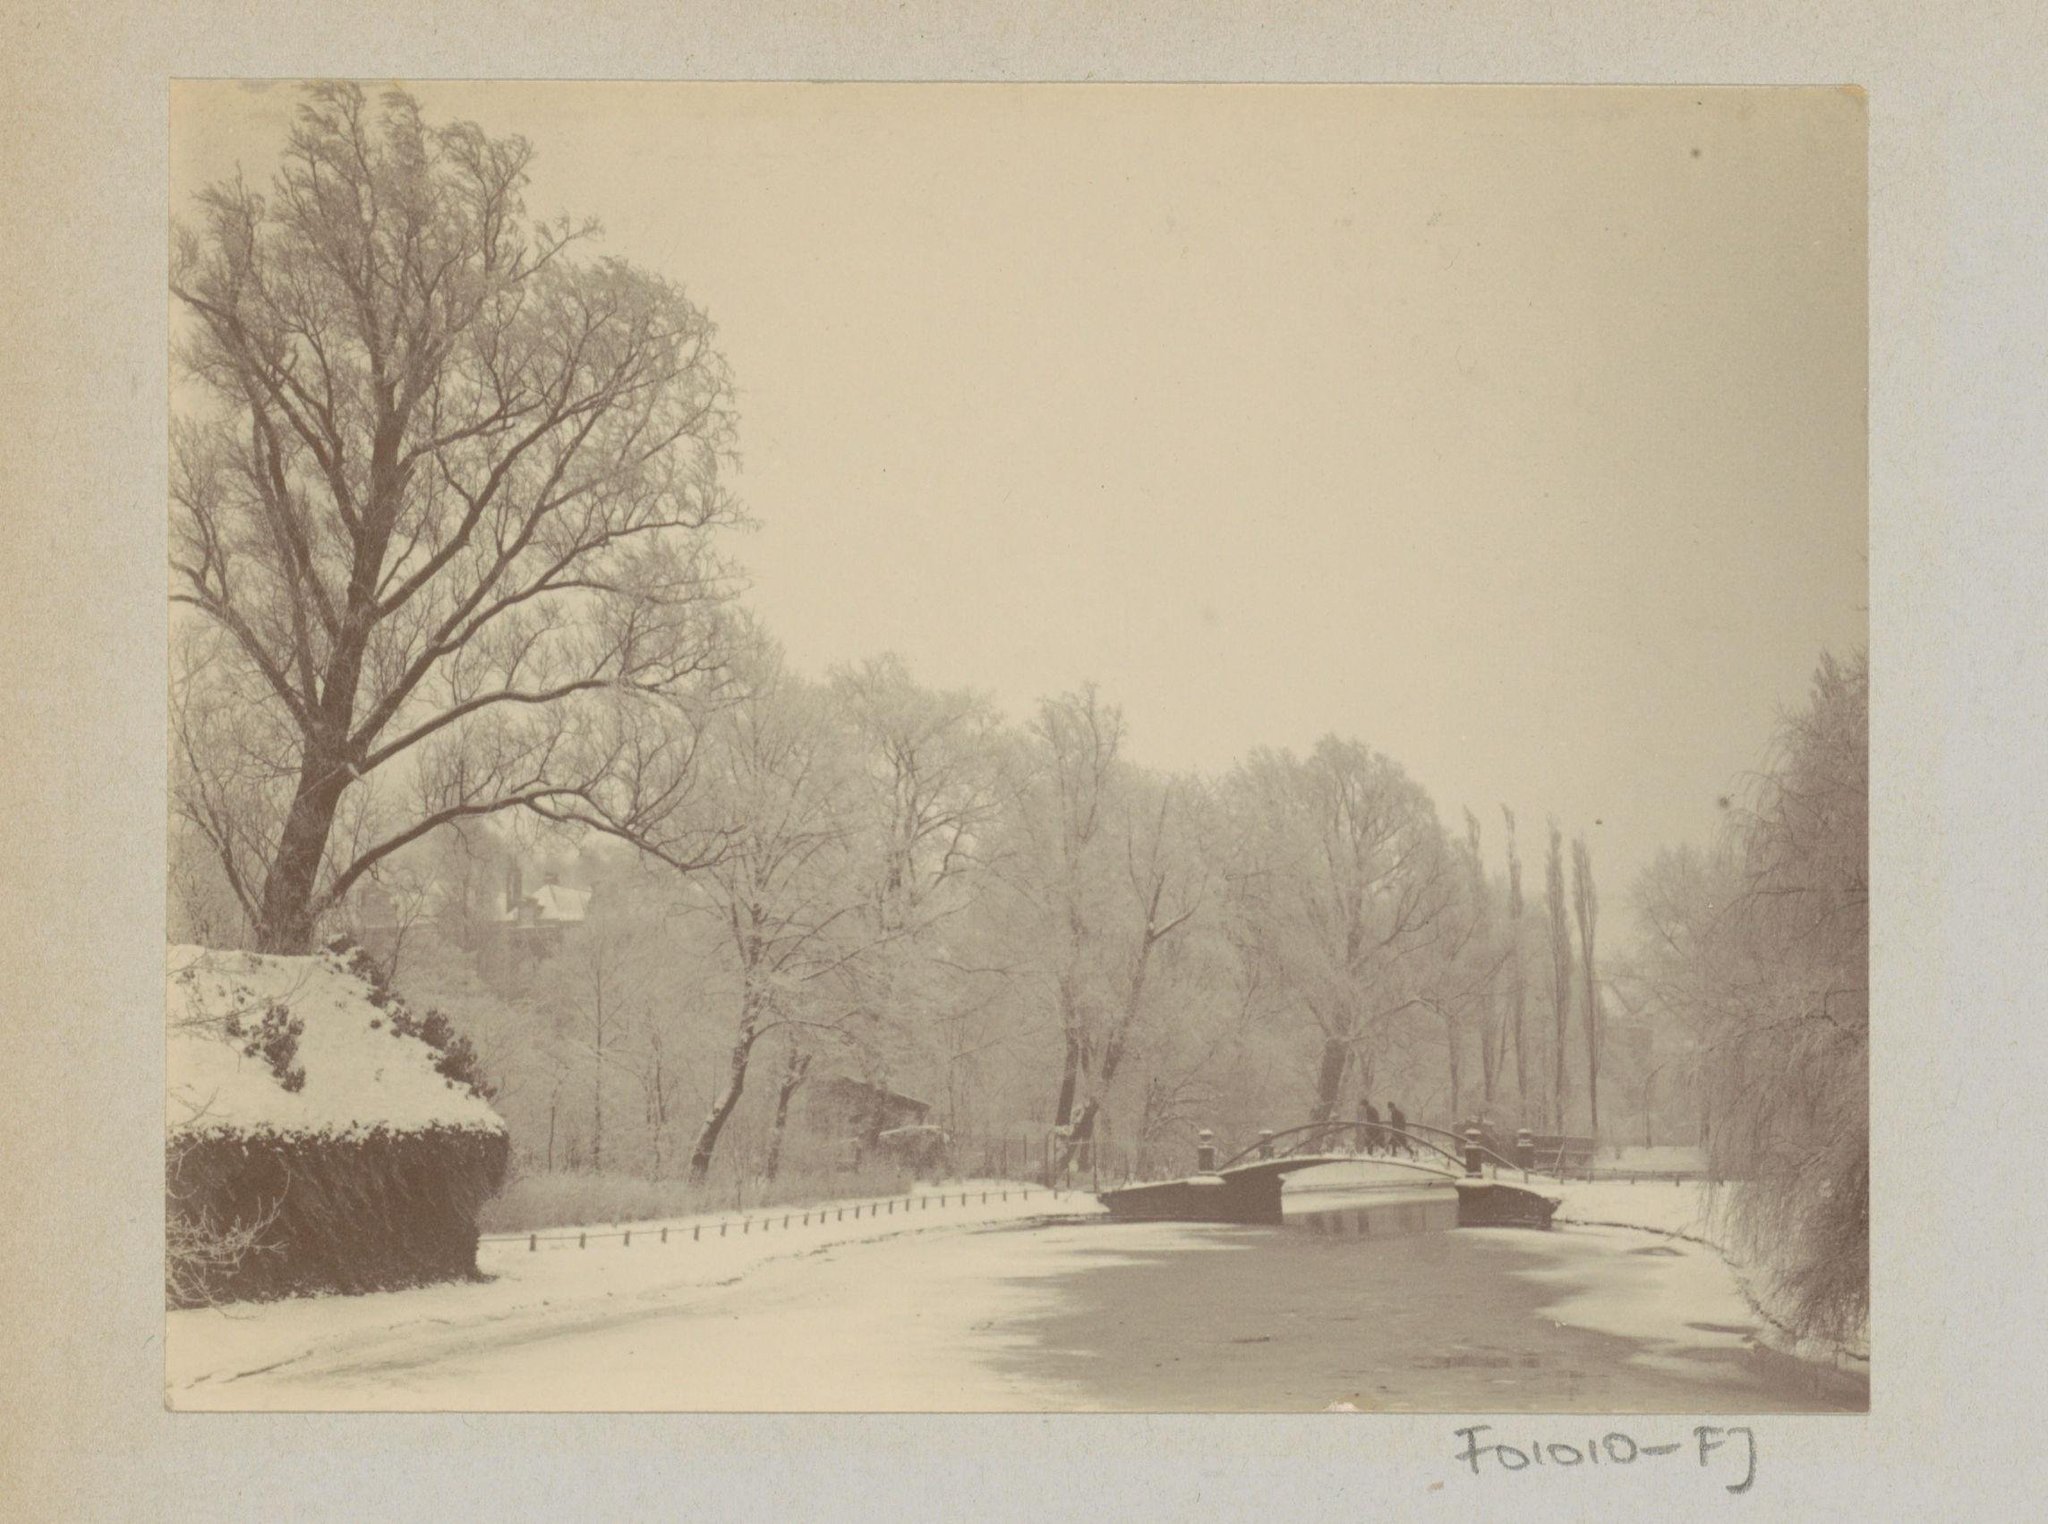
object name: photograph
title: Landschap in de sneeuw met brug en bomen, vermoedelijk een park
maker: Anonymous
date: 1900-1910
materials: photographic support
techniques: daylight paper print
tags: garden, landscape with bridge, viaduct or aqueduct, winter landscape; landscape symbolizing winter (the four seasons of the year), snow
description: Onderdeel van Familiealbum met onder meer foto's van Wijnhandel Kraaij & Co. Bordeaux-Amsterdam.